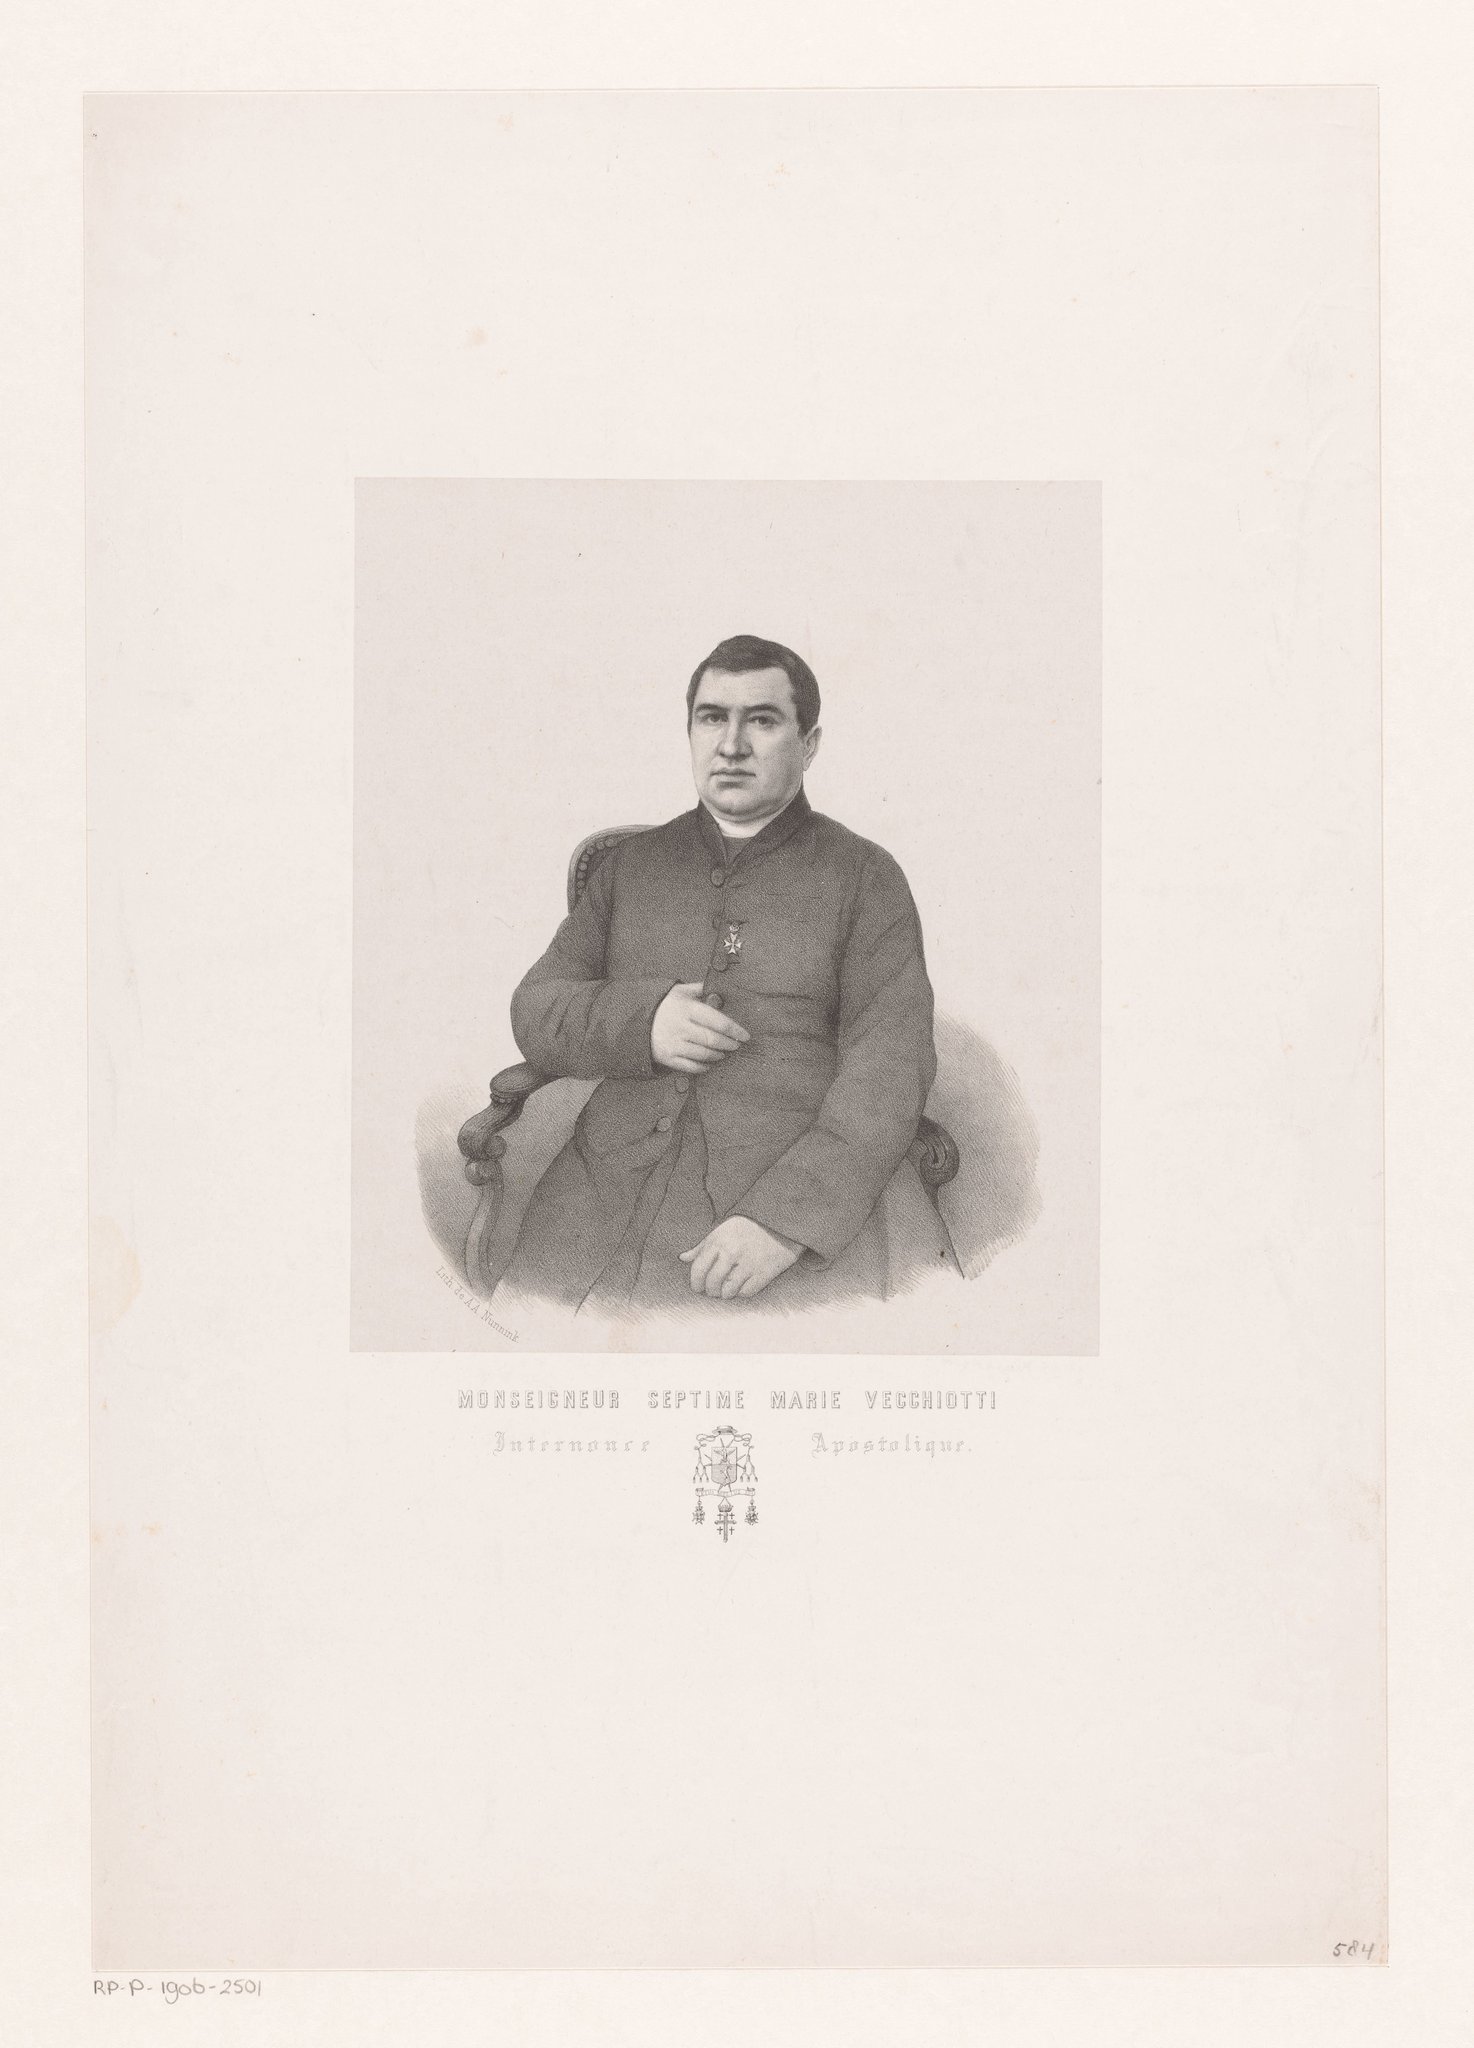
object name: print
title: Portret van Septime Marie Vecchiotti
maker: albertus anthonius nunnink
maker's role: print maker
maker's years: 1816-1895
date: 1826-1895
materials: paper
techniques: lithograph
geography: netherlands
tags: clergyman, historical persons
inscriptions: collector's mark: Lugt 2228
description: Onder het portret een wapenschild met kardinaalshoed.